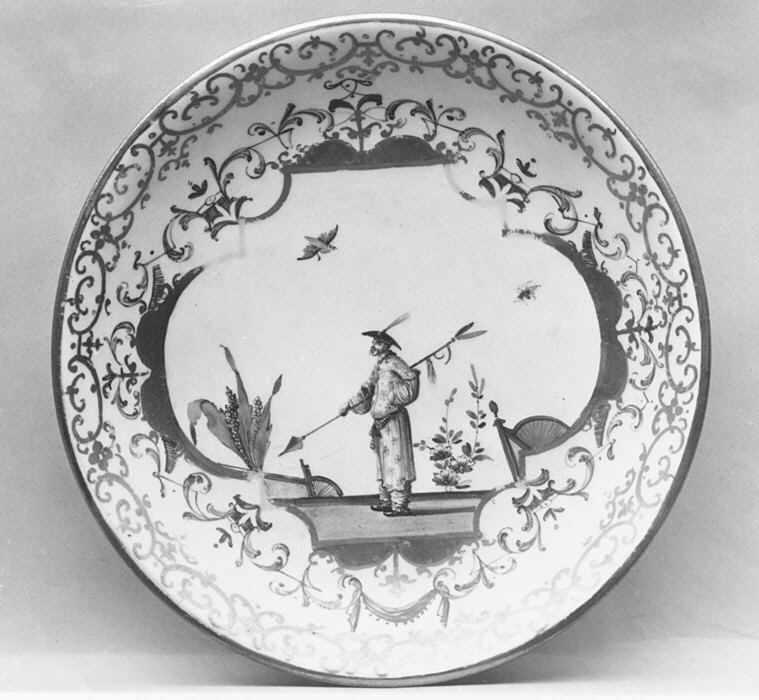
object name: saucer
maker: meissen manufactory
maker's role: manufactory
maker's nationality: german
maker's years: 1710-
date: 1725-1730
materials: hard paste porcelain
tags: birds,men